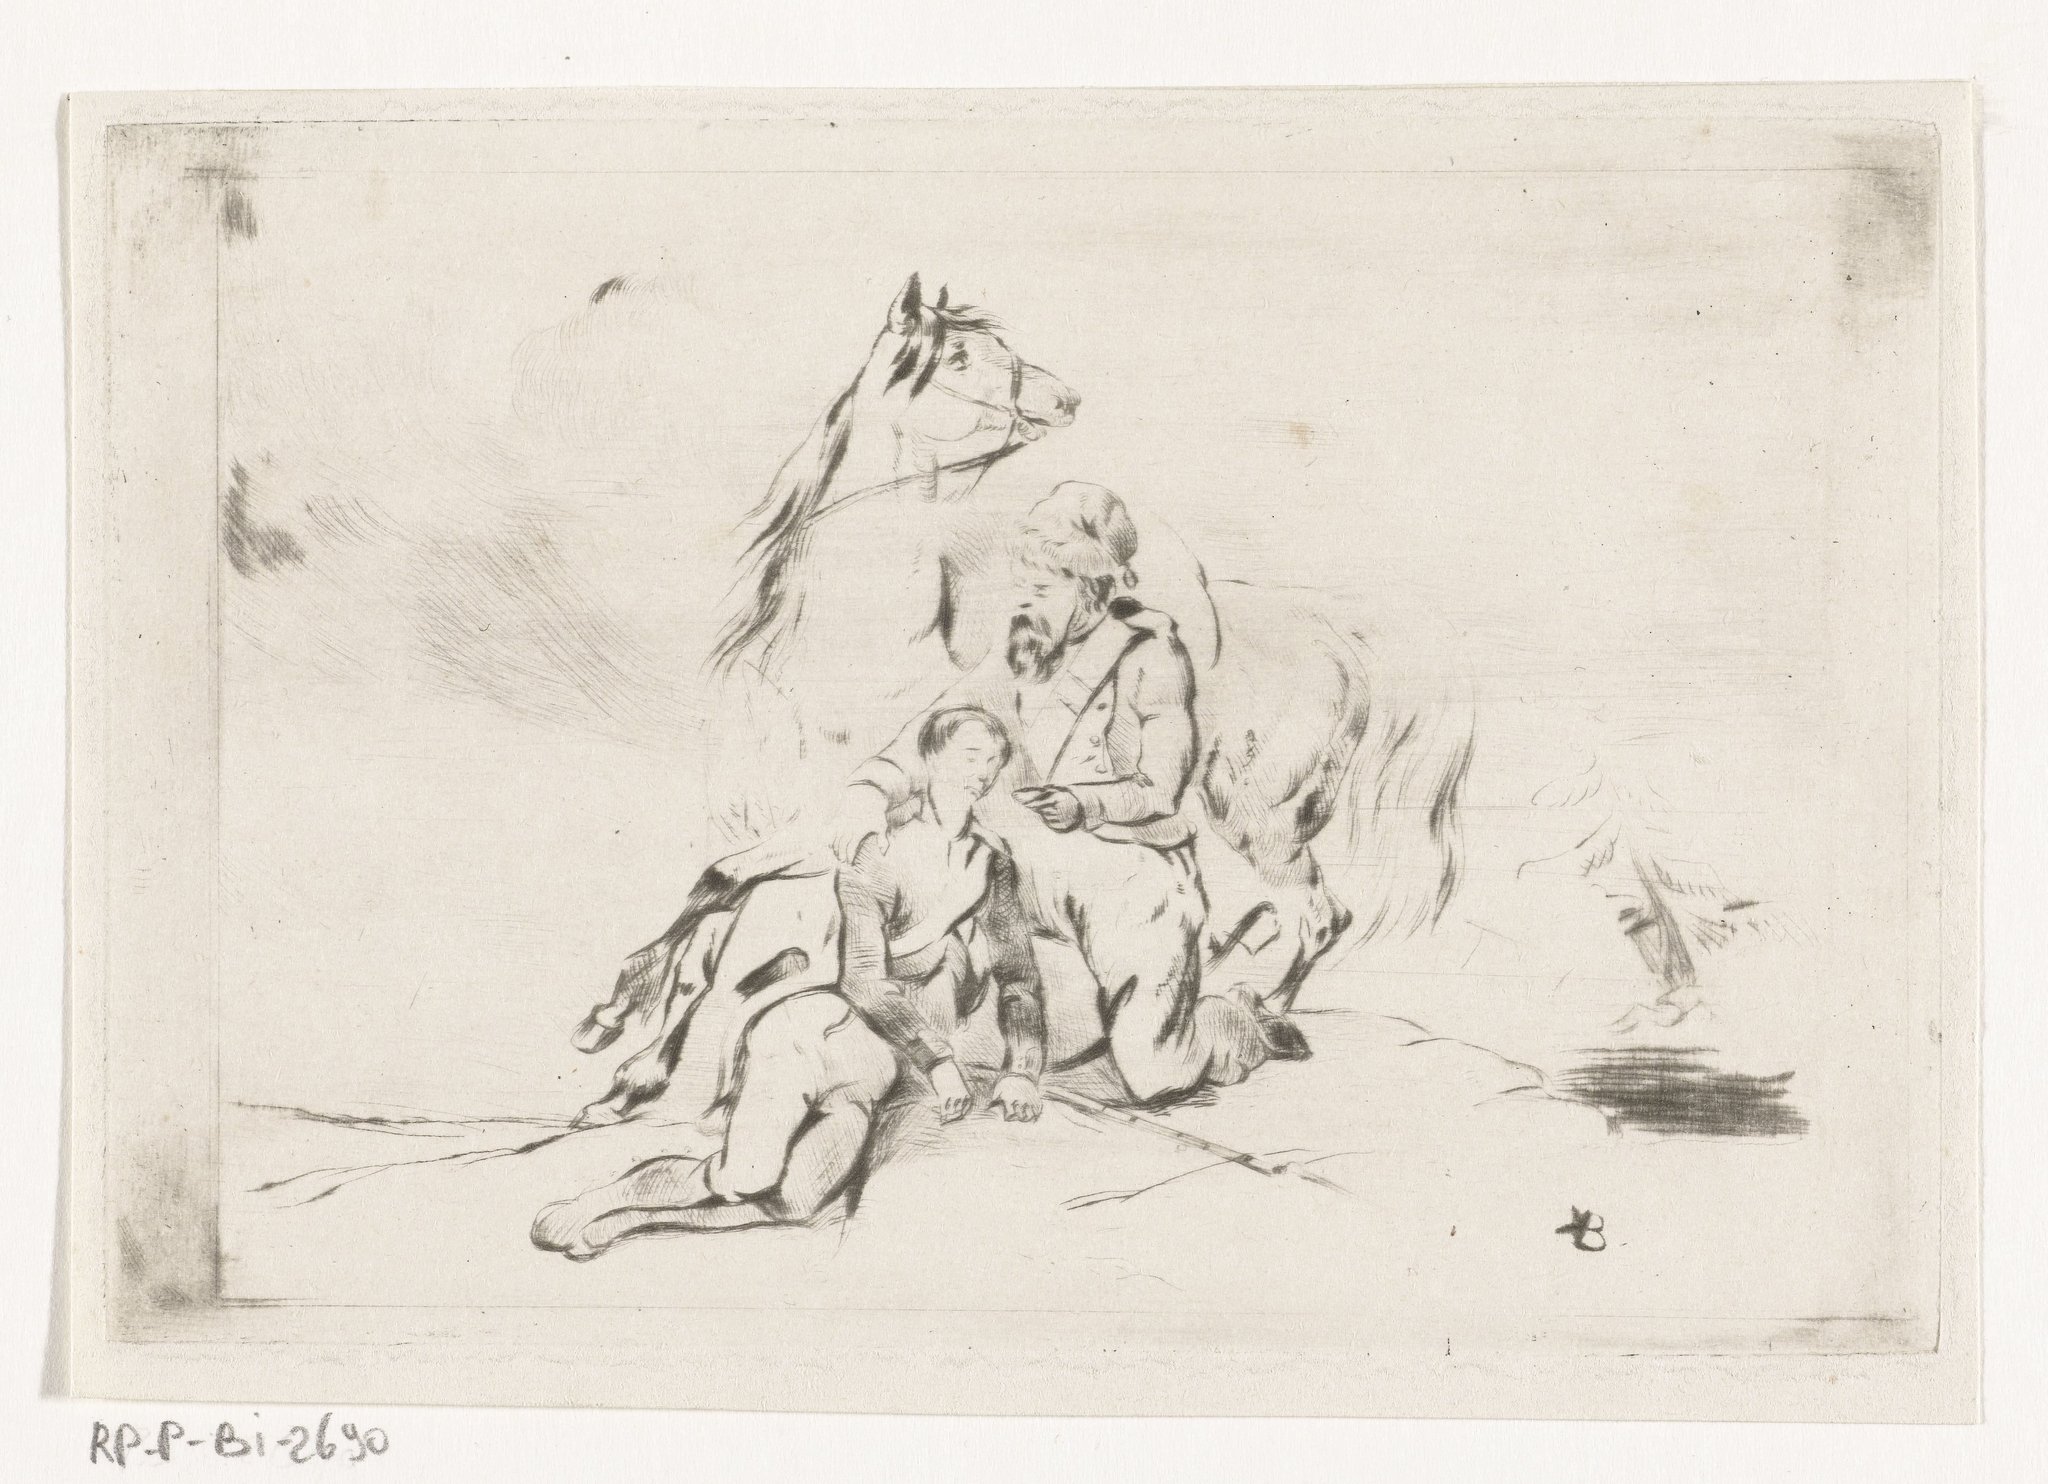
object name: print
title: Gewonde soldaat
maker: karel frederik bombled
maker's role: draughtsman, print maker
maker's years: 1822-1902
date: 1832-1902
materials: paper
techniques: drypoint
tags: warfare; military affairs (+ cavalry, horsemen), medical aid and nursing of the sick and wounded on the battlefield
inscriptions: collector's mark: Lugt 2228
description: Een jonge soldaat ligt op de grond en wordt door een oudere soldaat verzorgd. De oudere soldaat zit op zijn knieën en geeft de jongen wat te drinken. Een paard staat achter hen.